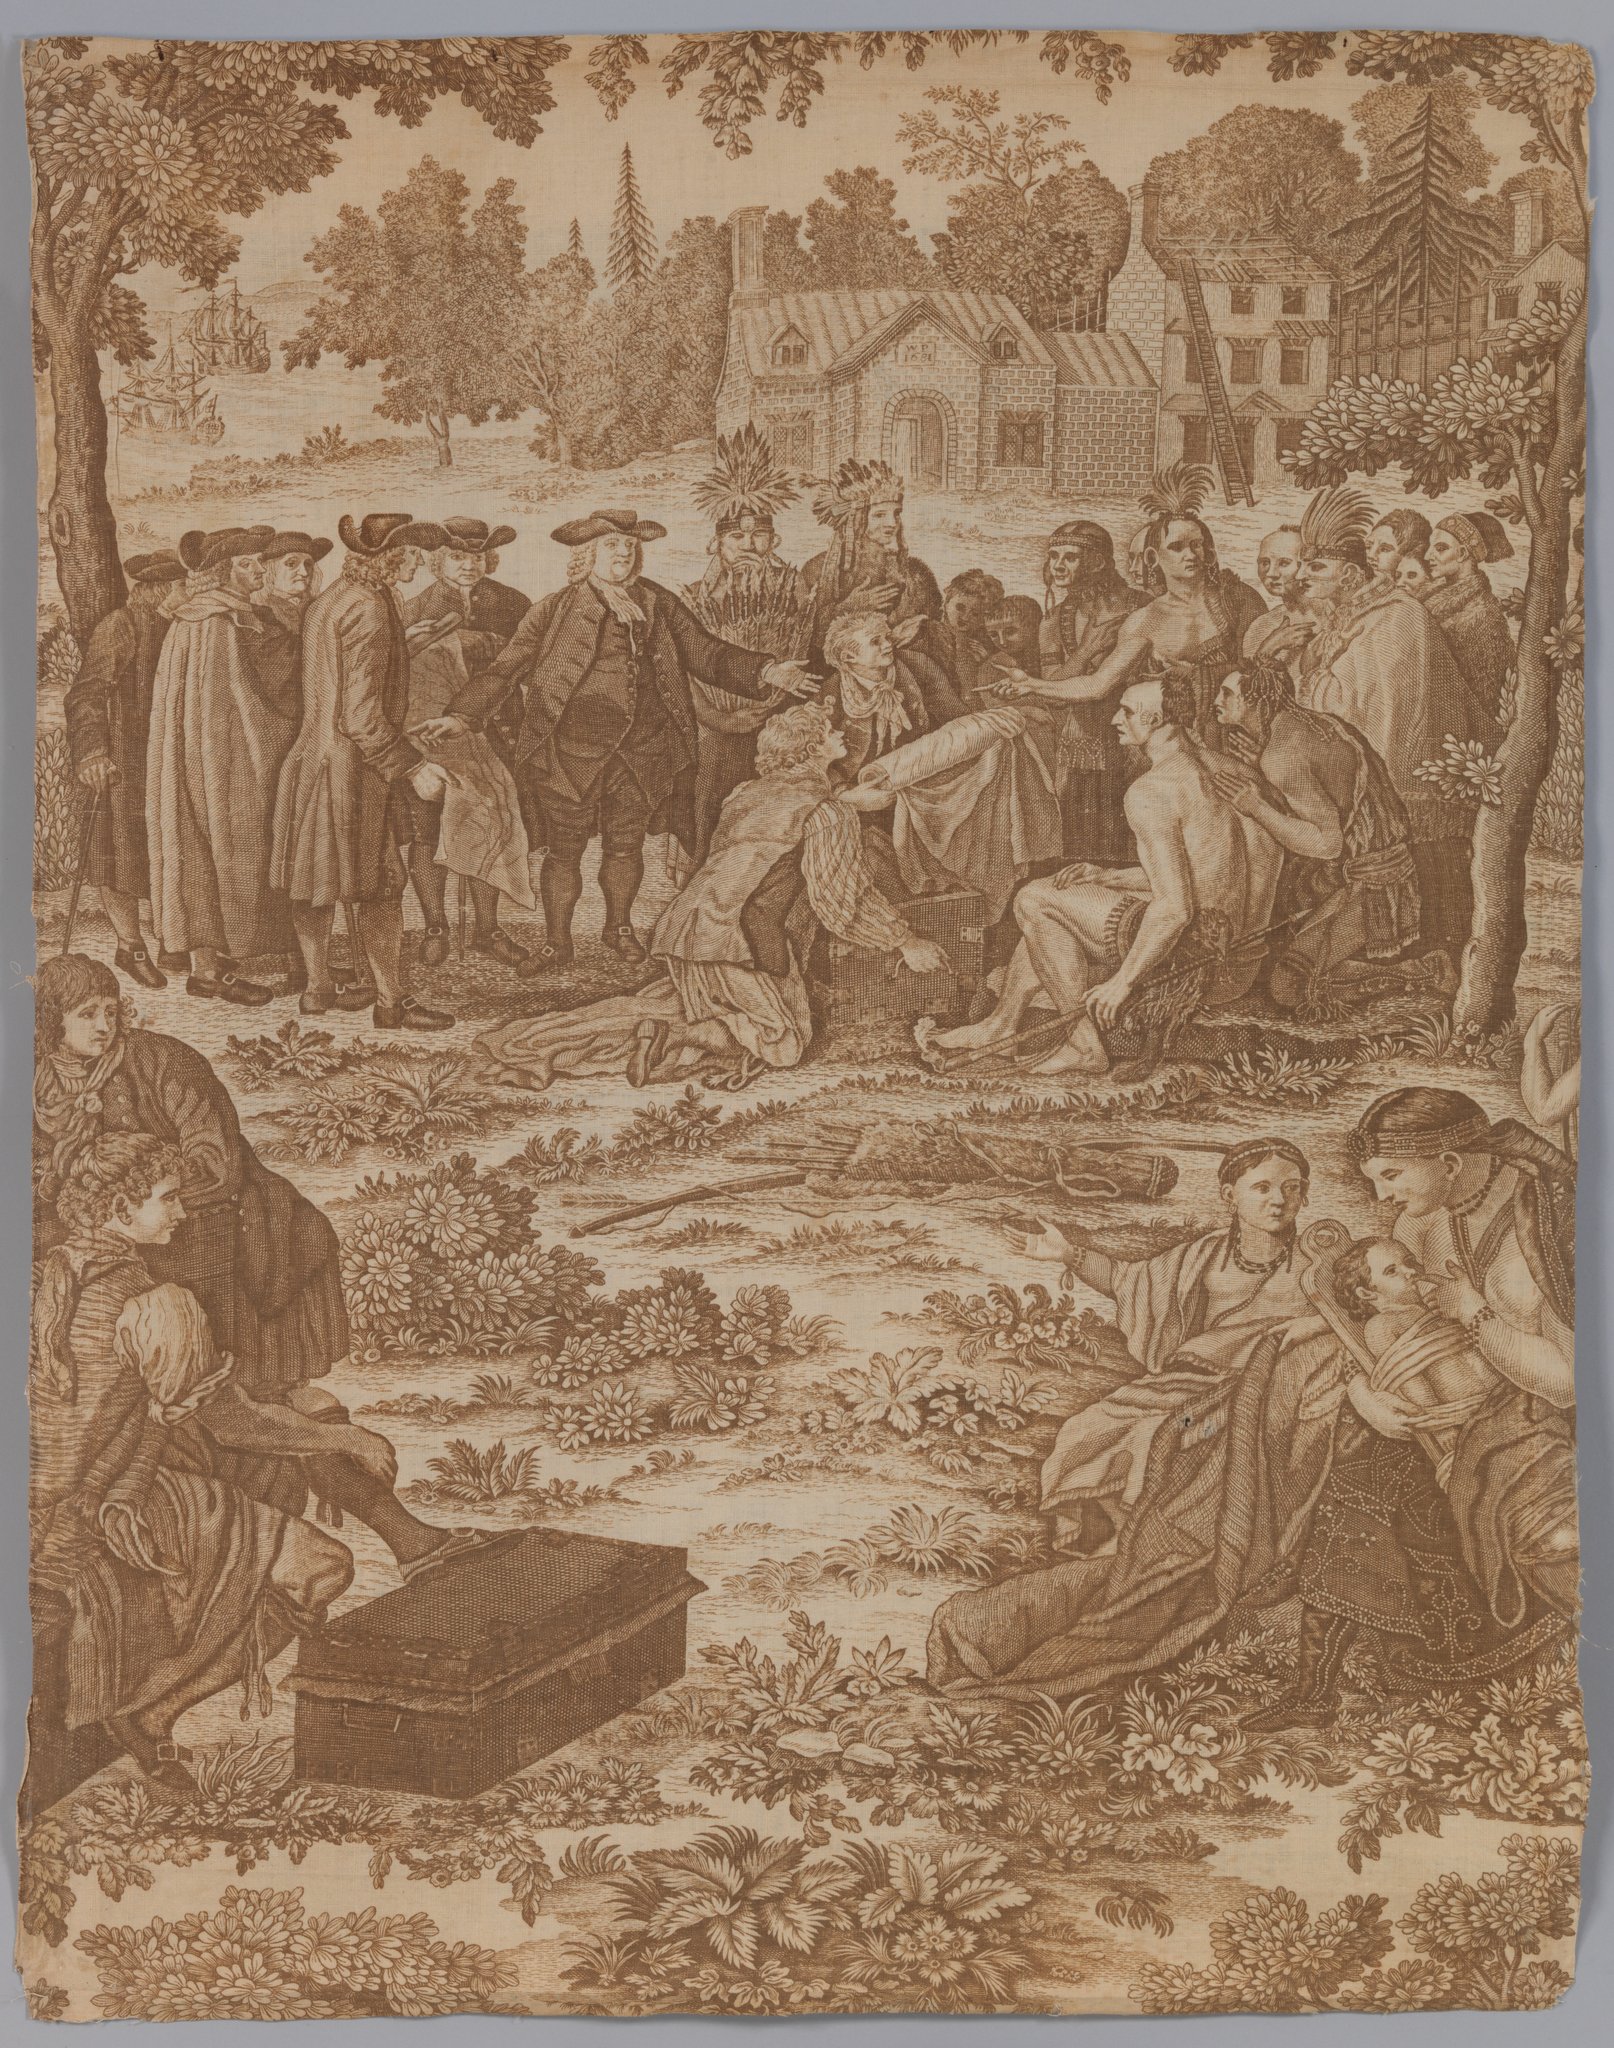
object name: piece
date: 1788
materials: cotton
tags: houses,infants,men,women